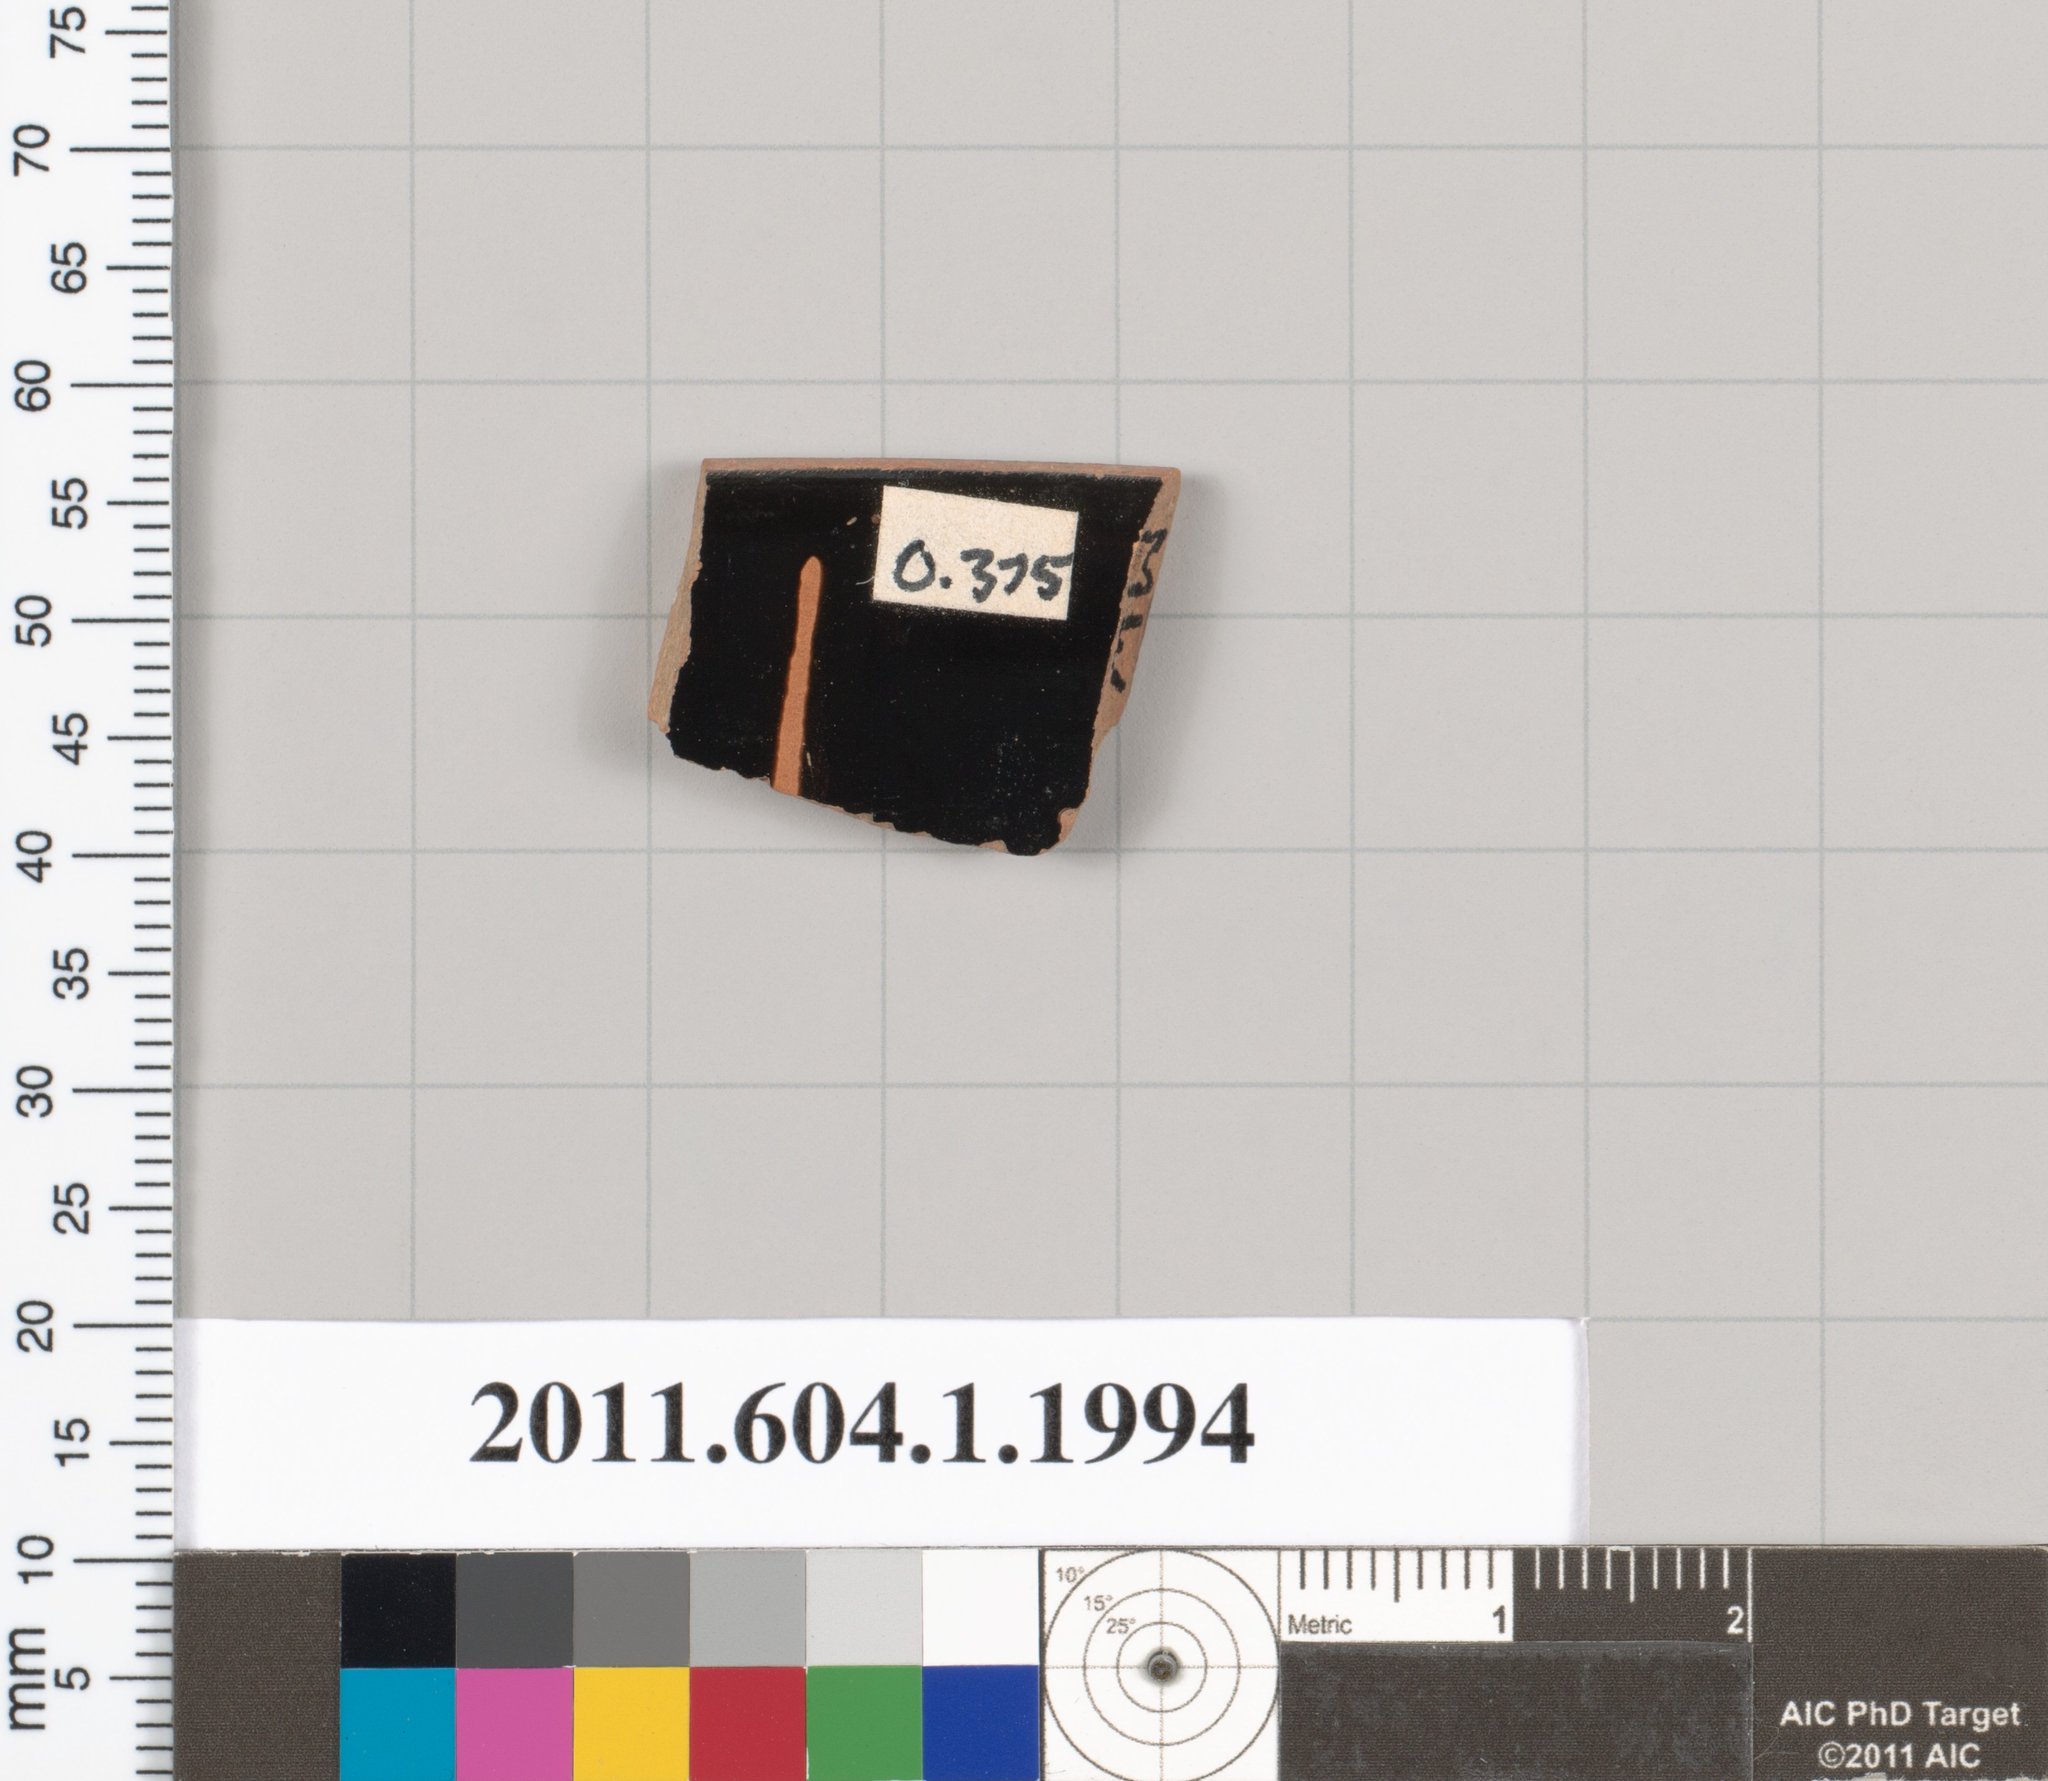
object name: kylix fragment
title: Terracotta rim fragment of a kylix (drinking cup)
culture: greek, attic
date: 475-451 BCE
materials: terracotta